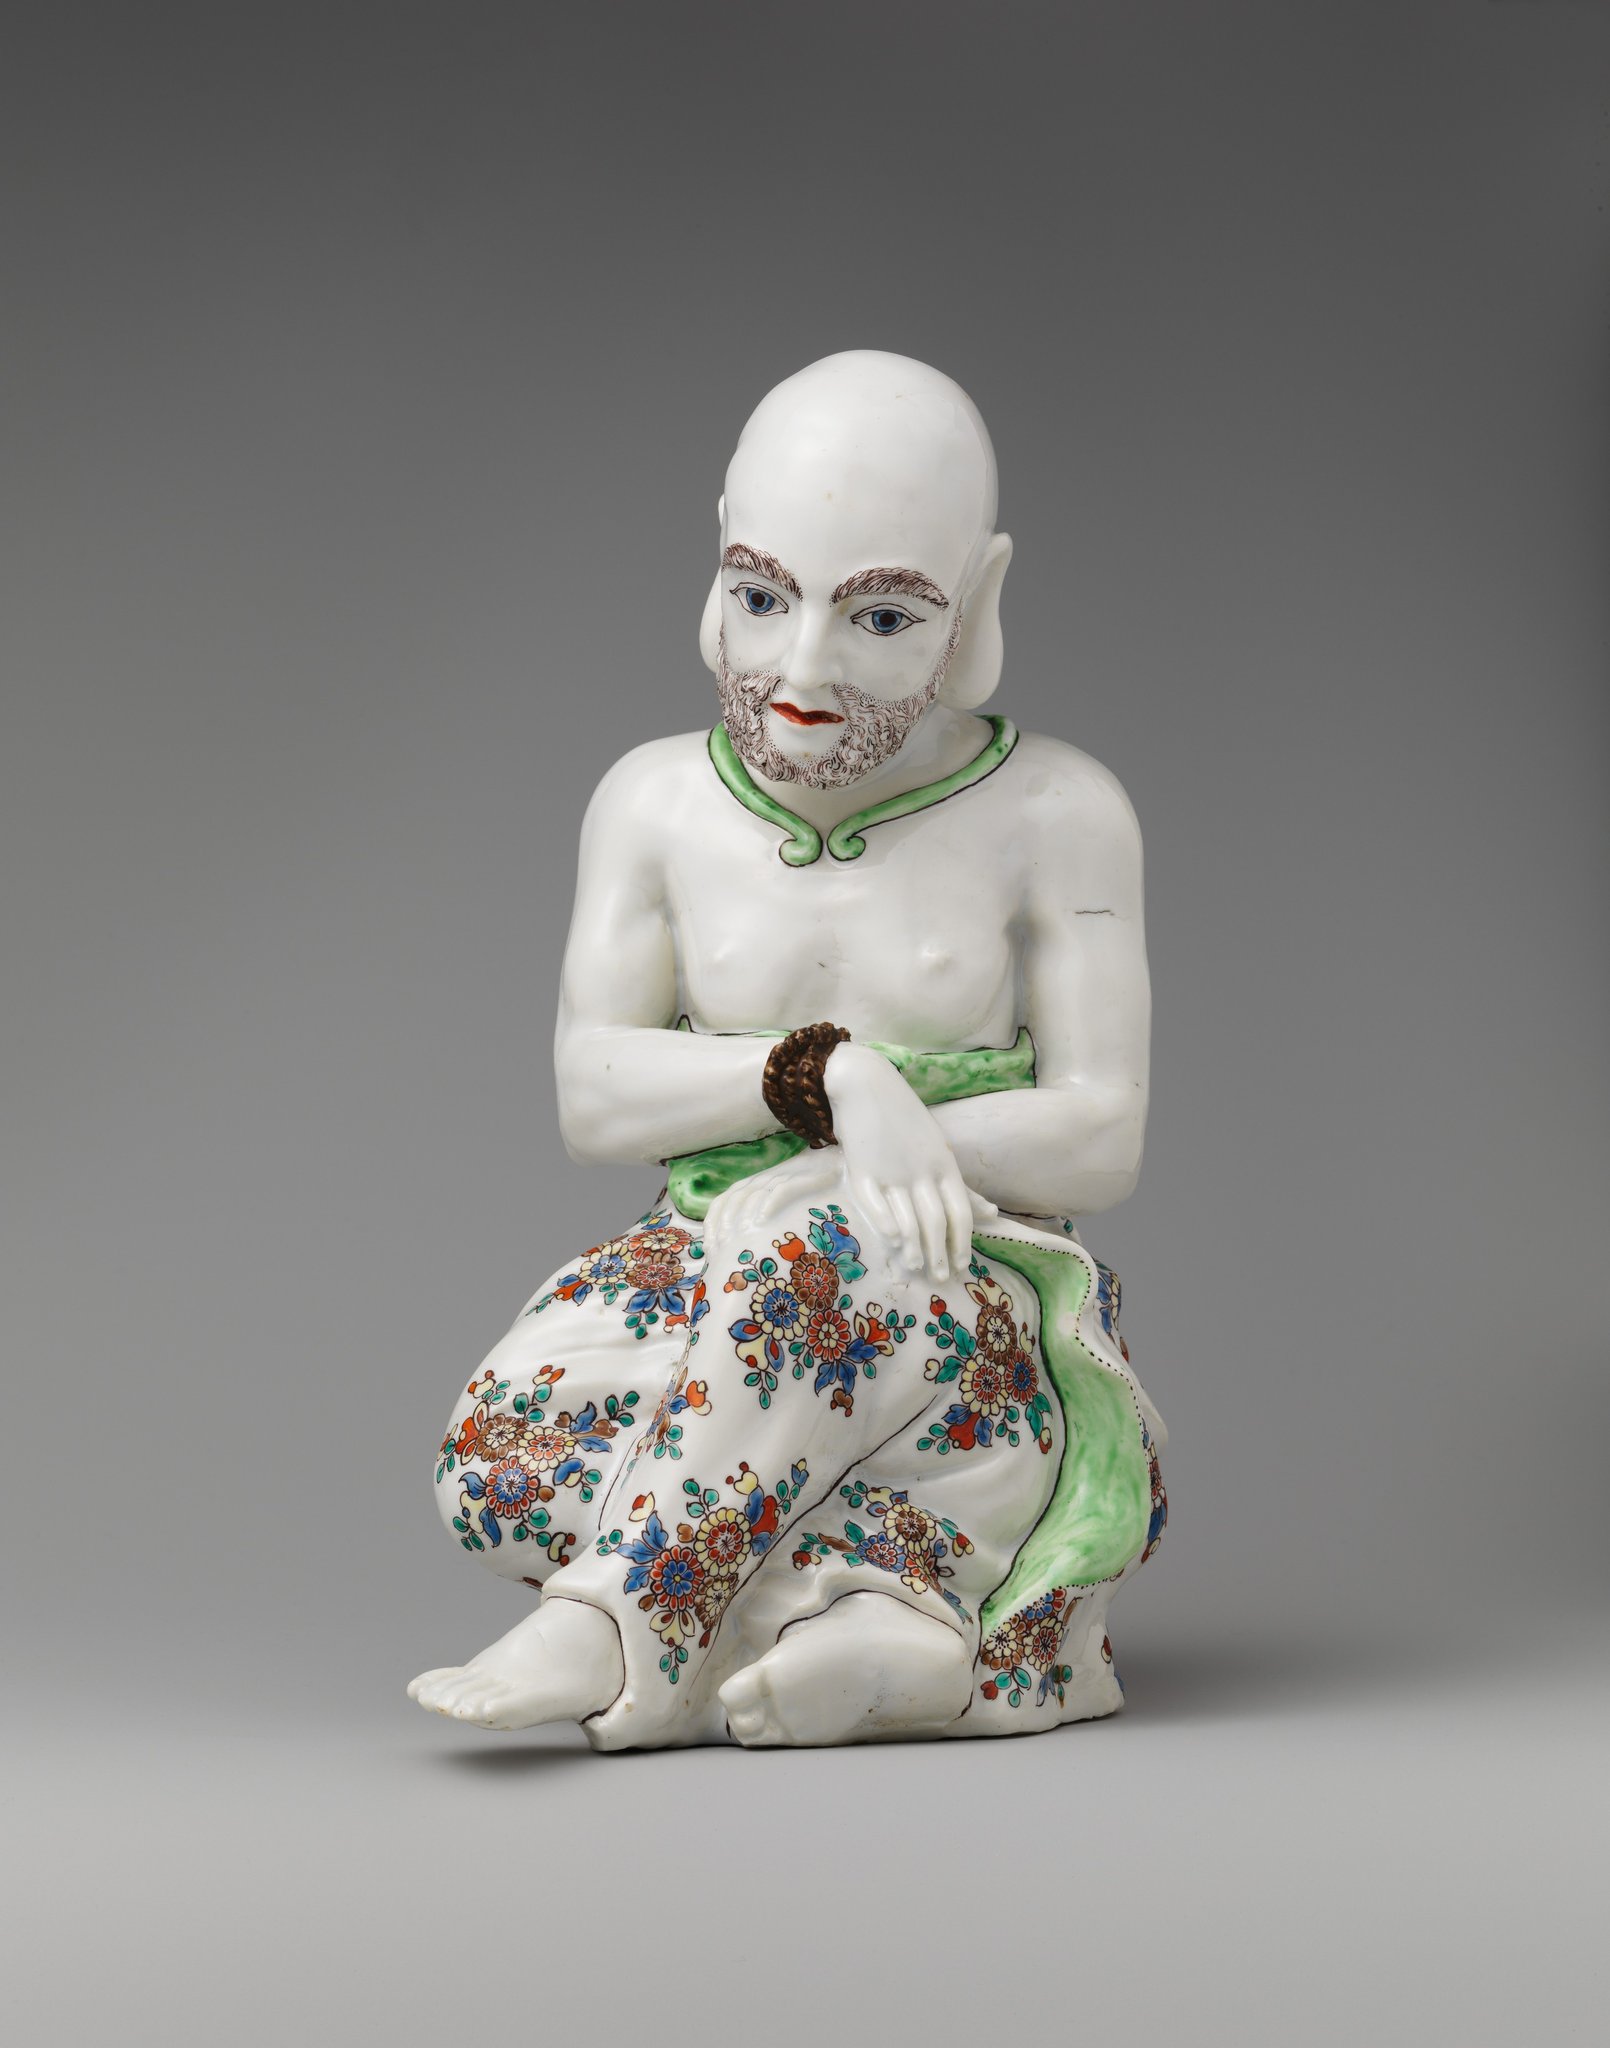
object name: figure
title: Buddhist Ascetic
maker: chantilly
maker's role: factory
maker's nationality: french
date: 1735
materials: soft paste porcelain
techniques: glazing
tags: men